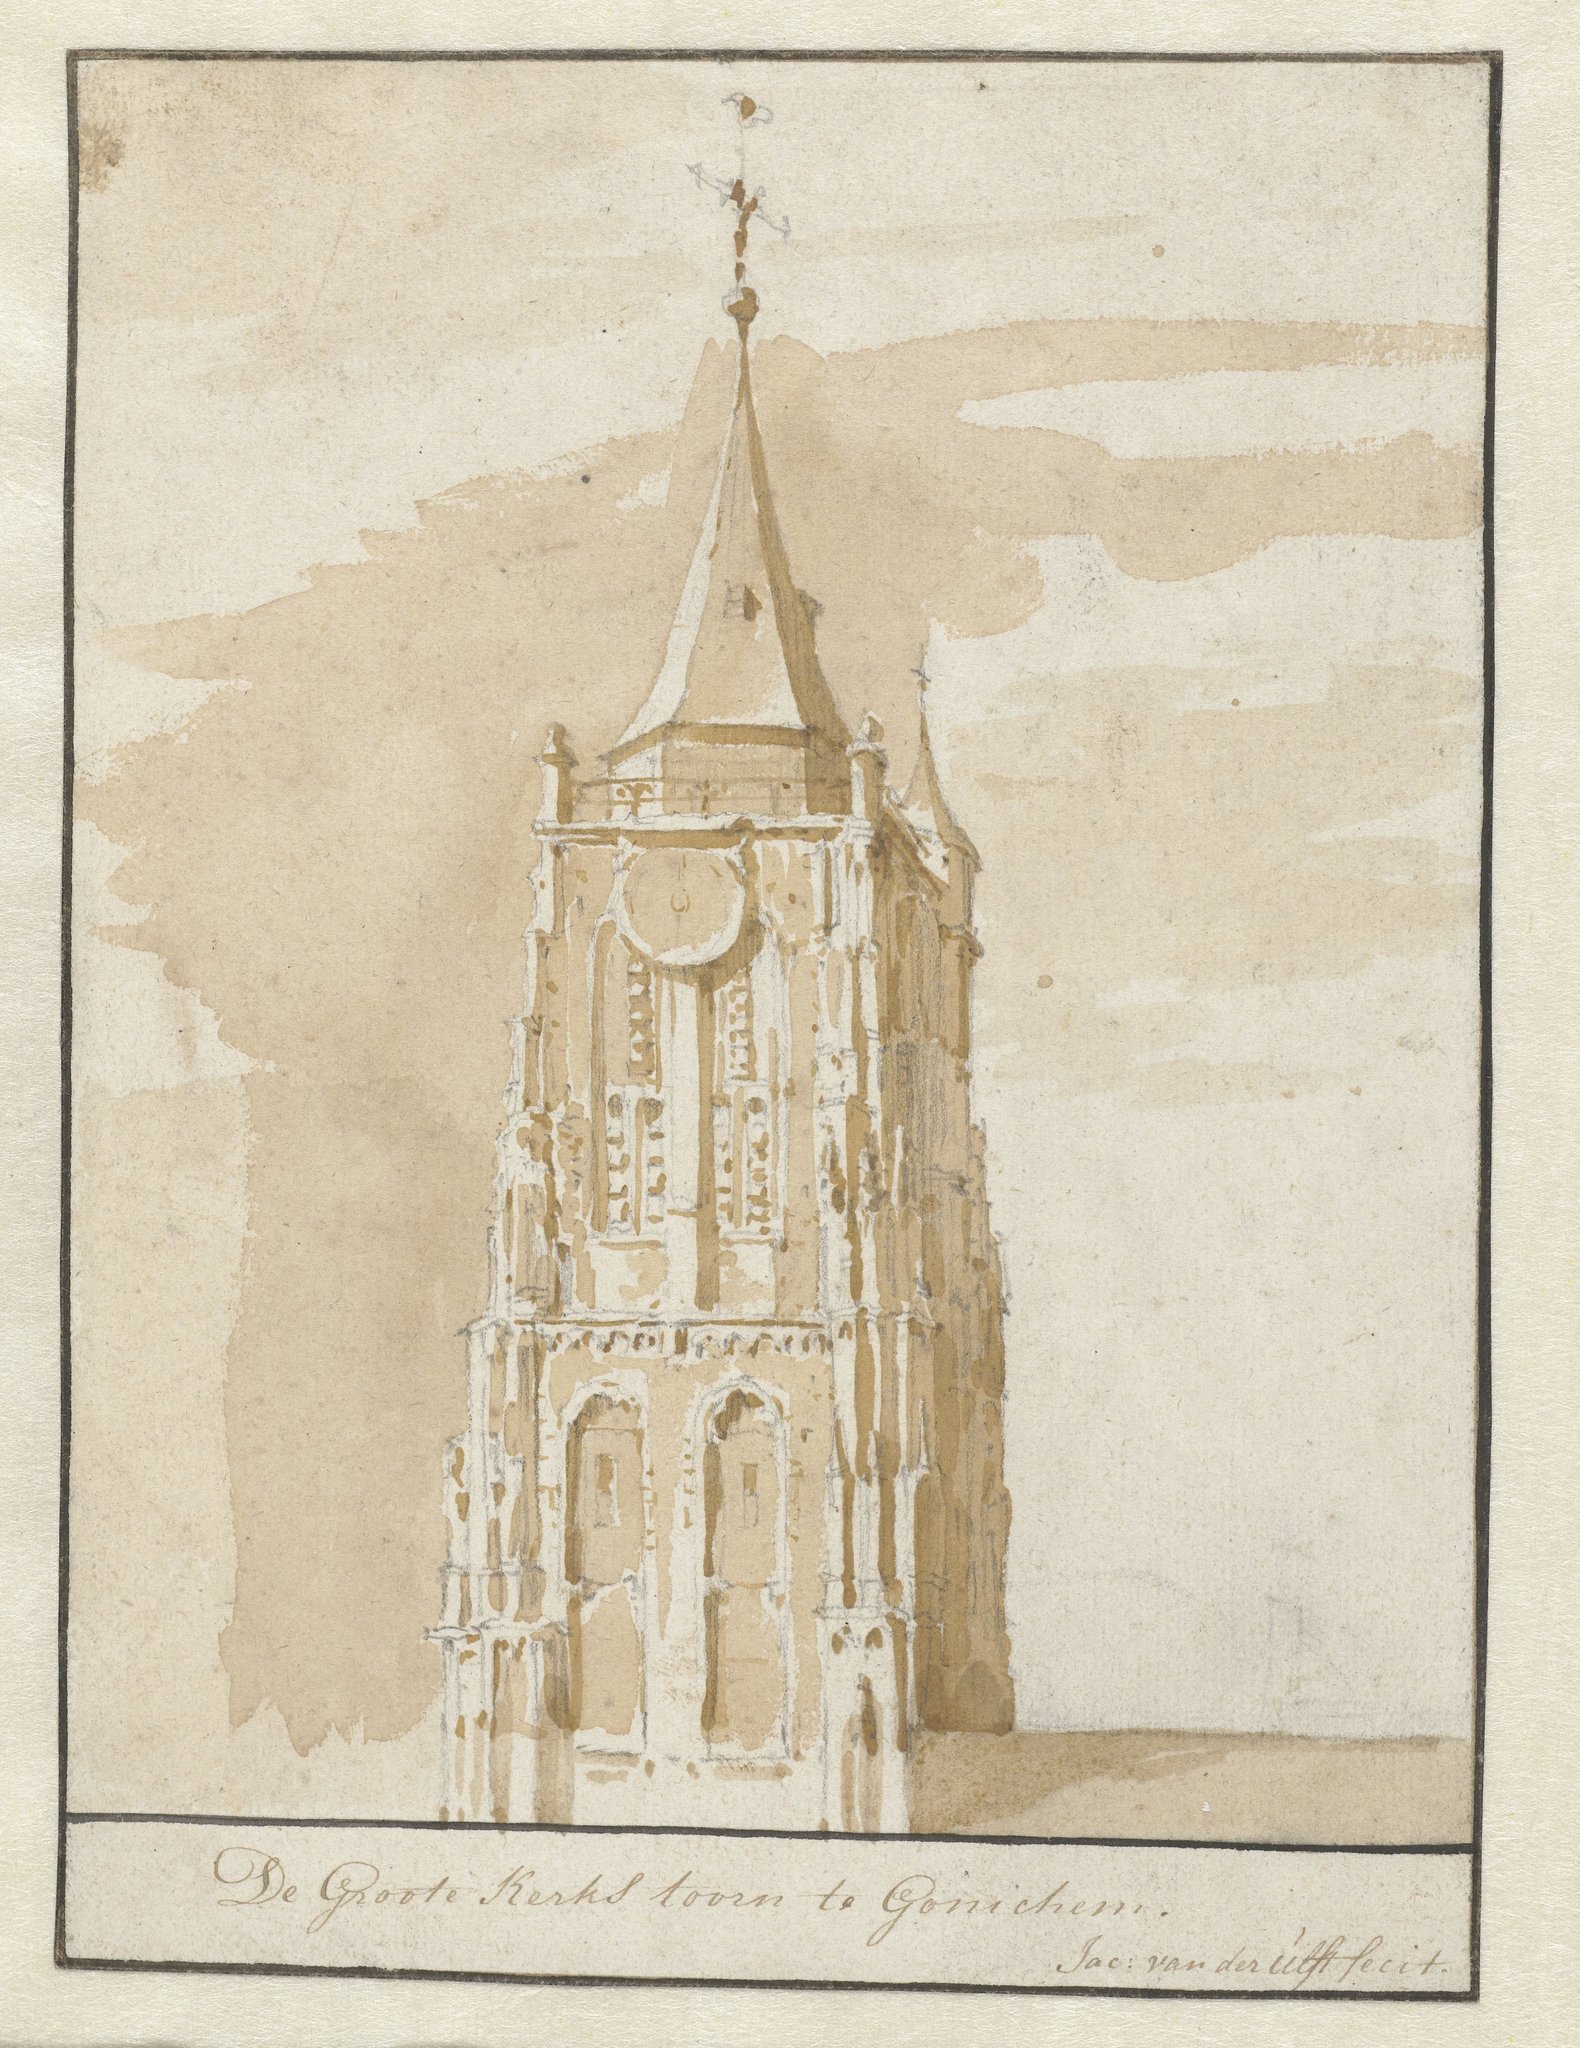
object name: drawing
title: Toren van de Grote Kerk te Gorinchem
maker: jacob van der ulft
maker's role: draughtsman, painter, print maker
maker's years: 1627-1689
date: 1637-1689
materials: paper, pencil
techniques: brush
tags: church (exterior), parts of church exterior and annexes: tower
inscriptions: : ‘De Groote Kerks toorn te Gorichem’